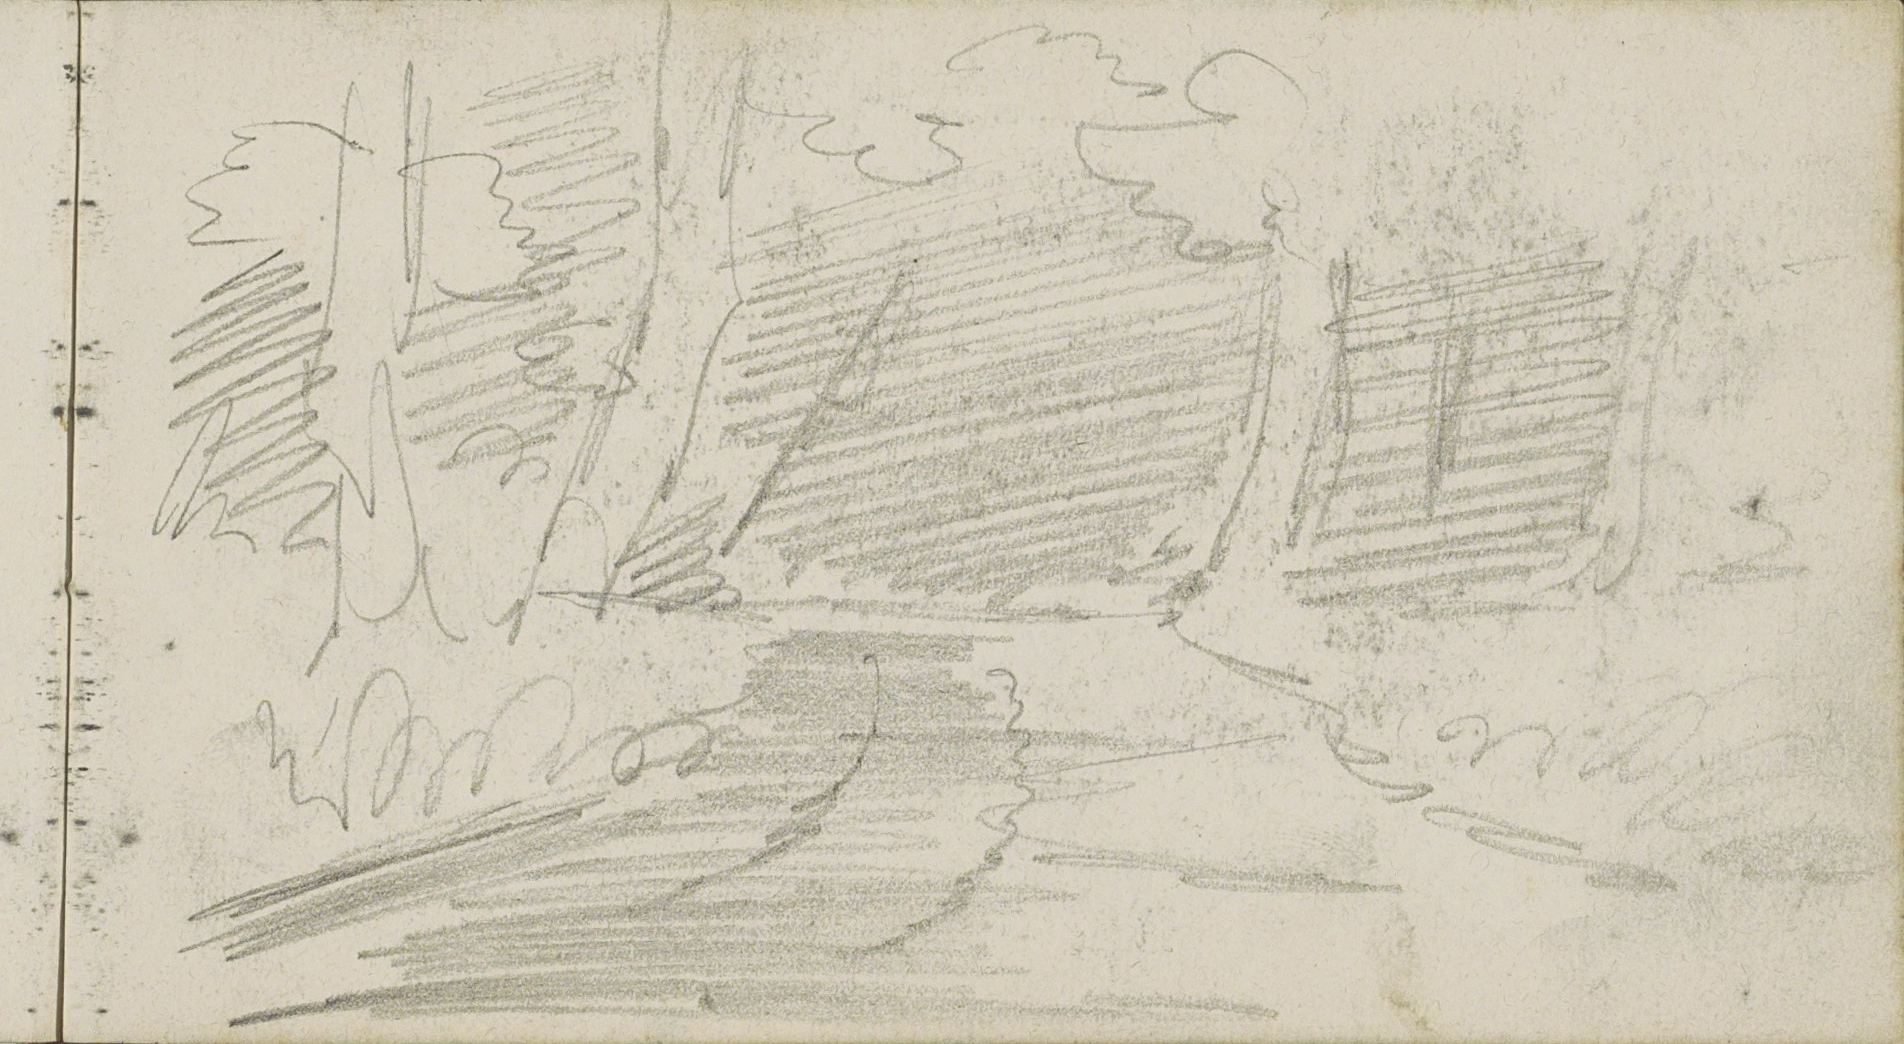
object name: sketchbook leaf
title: Bospad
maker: Anonymous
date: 1865-1874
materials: paper, pencil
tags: forest path or lane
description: Blad 4 recto uit een schetsboek met 39 bladen.